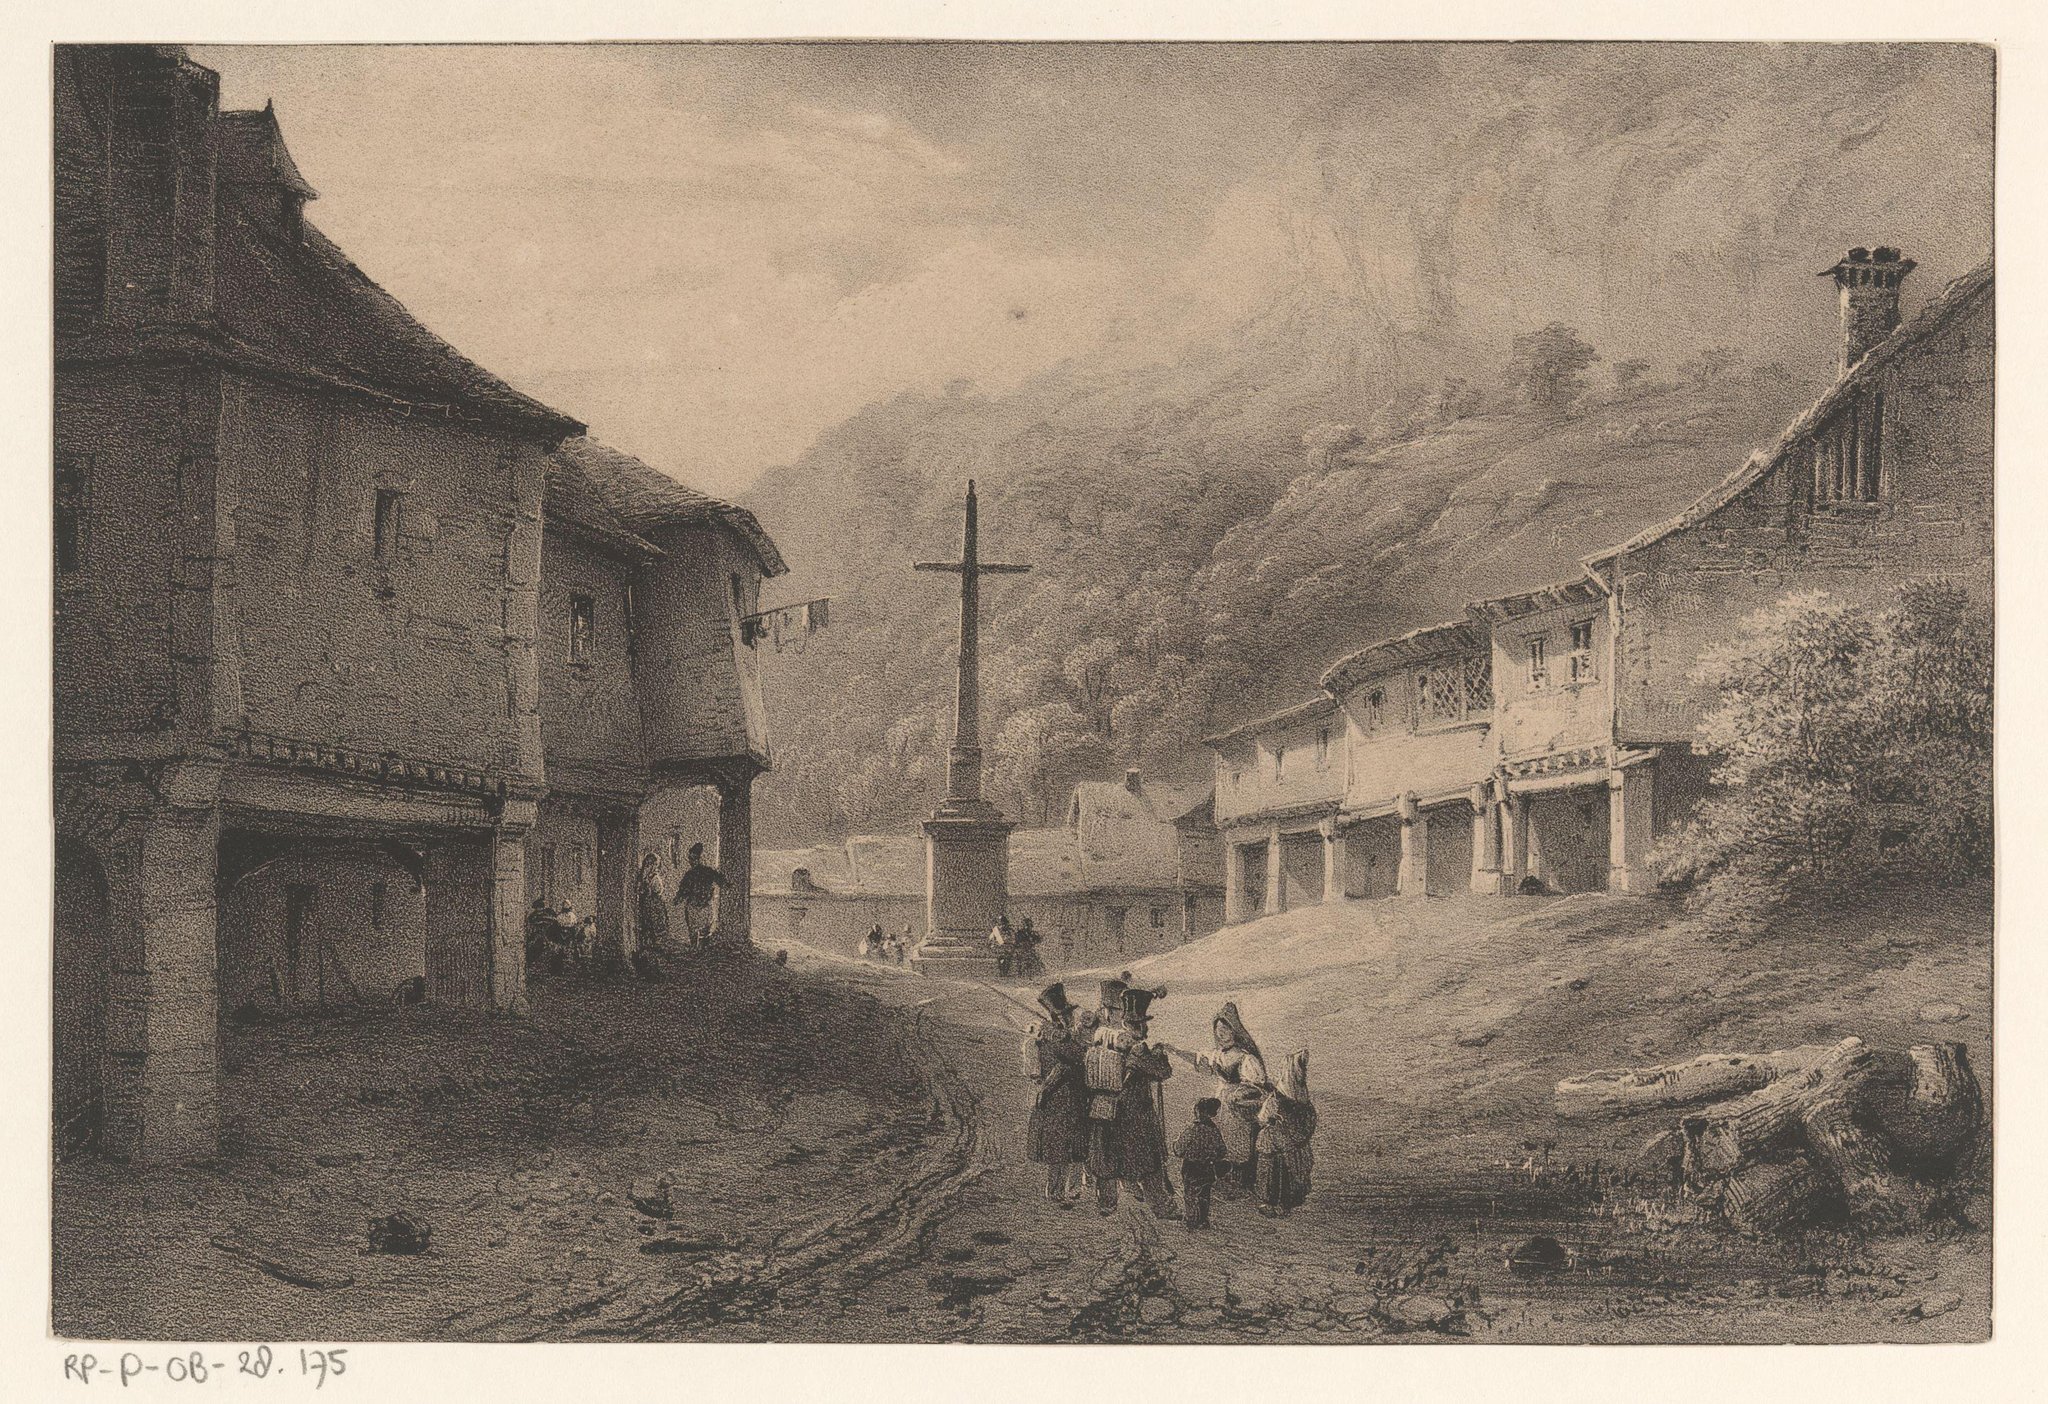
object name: print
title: Bergdorp met monument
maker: Anonymous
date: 1809-1899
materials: paper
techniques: lithograph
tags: village, public road in village, mountains (+ landscape with figures, staffage)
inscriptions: collector's mark: Lugt 2228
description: Links en rechts van een zandweg staan huizen. Op het plein verderop staat een kruis op een sokkel. Op de weg staat een groepje figuren waaronder soldaten.